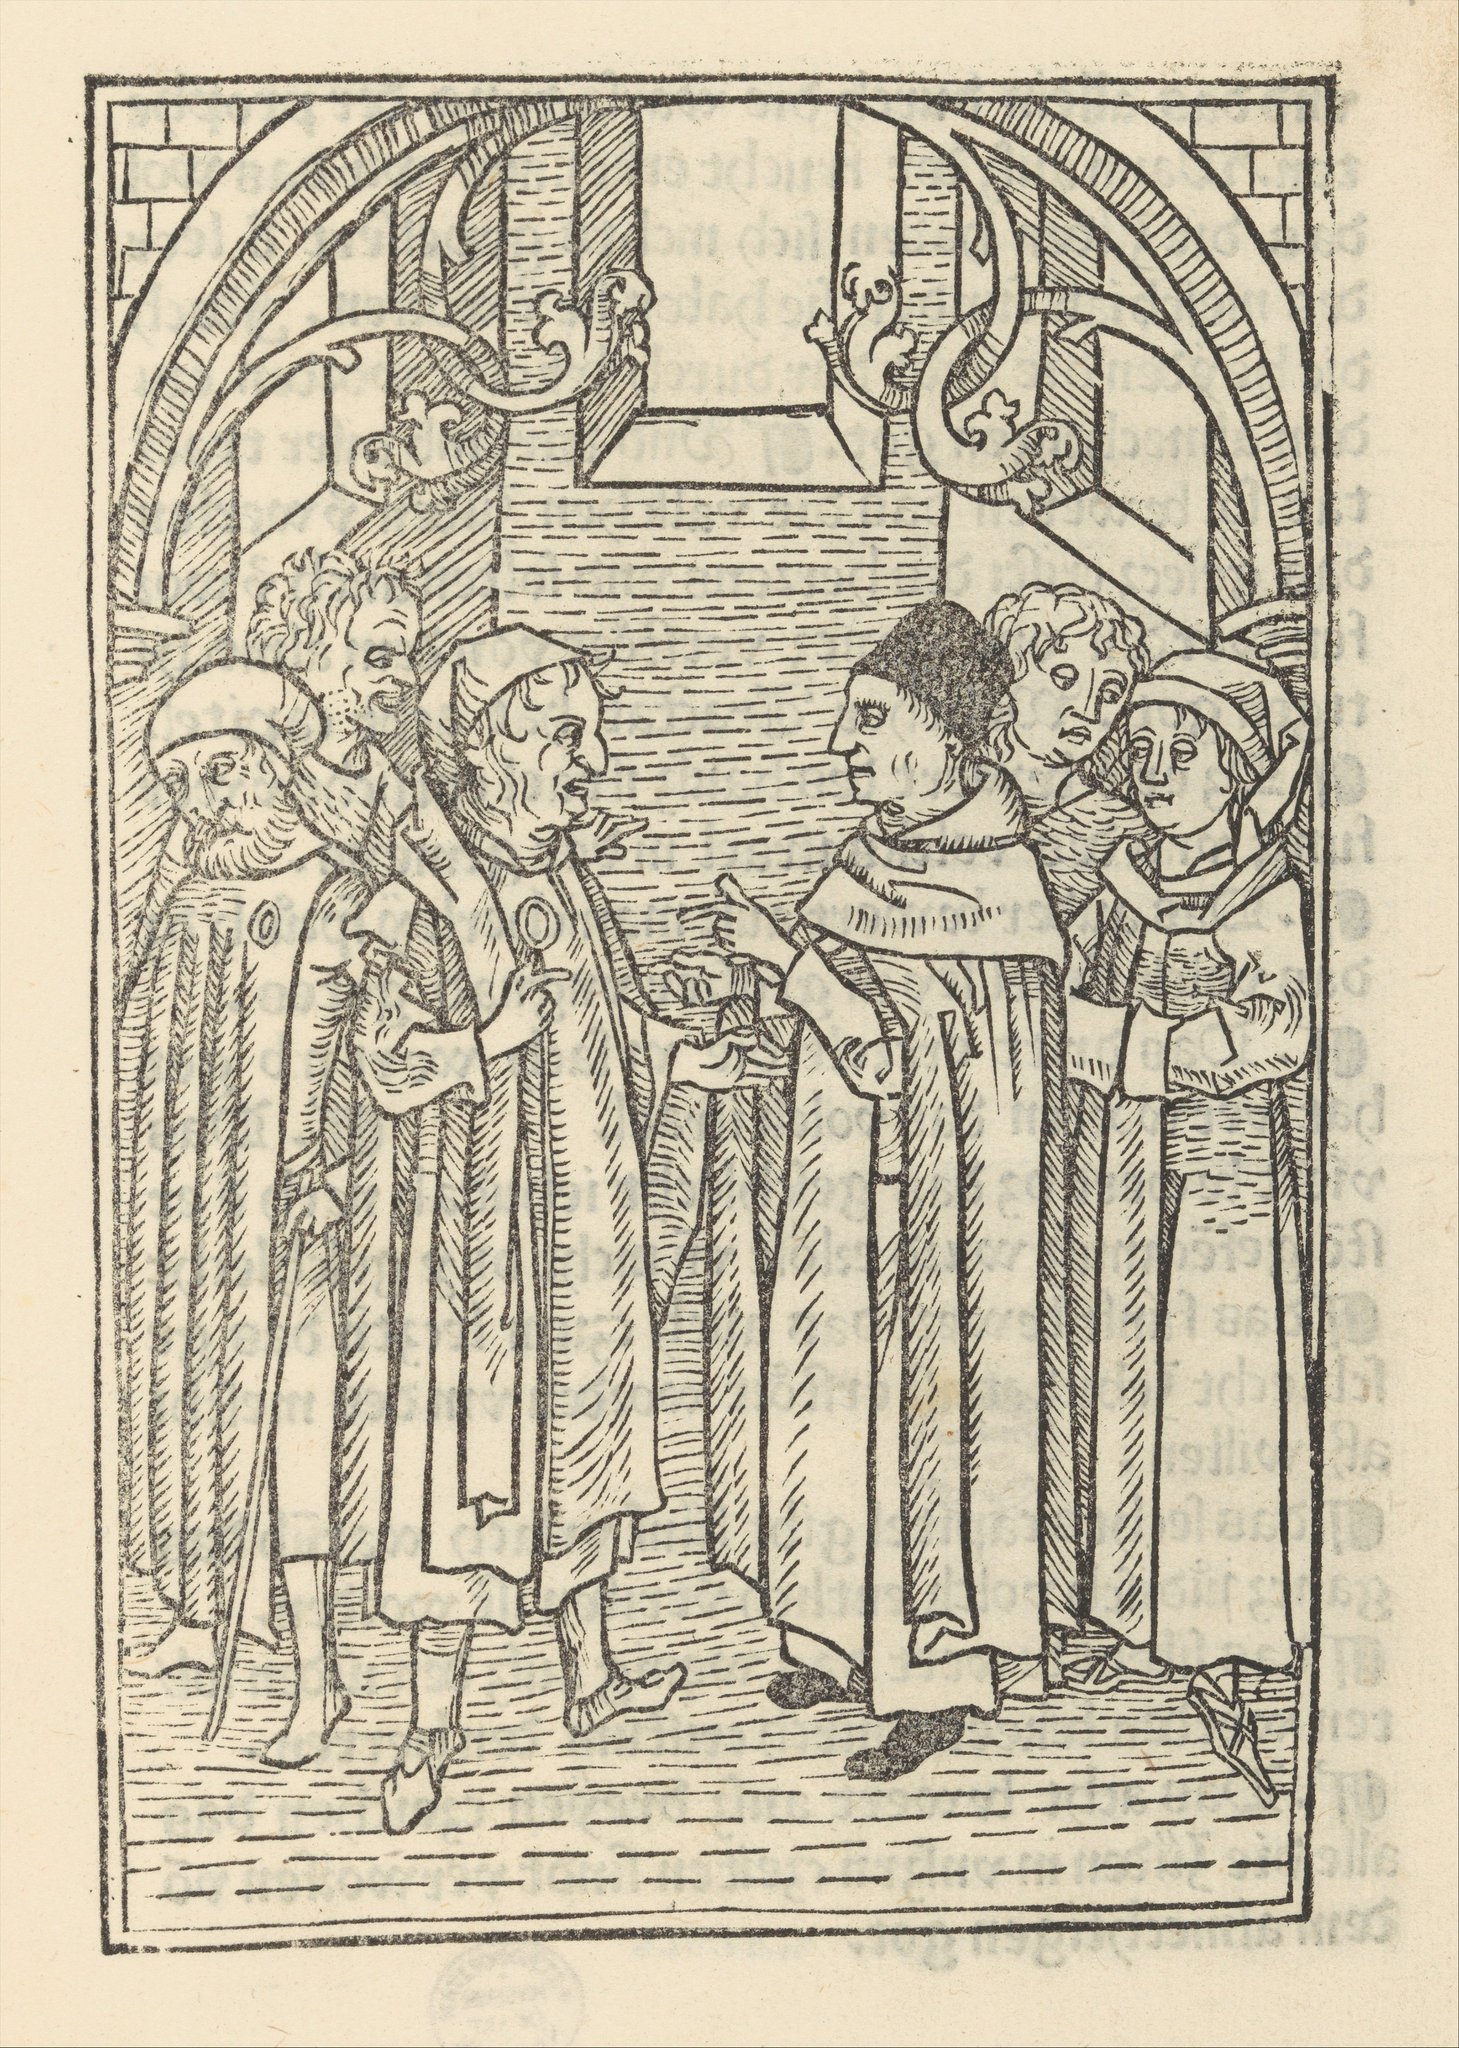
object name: print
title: Page from "Stern des Meschiah"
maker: anonymous, german, 15th century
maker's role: artist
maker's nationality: german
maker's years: 1400-1500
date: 1477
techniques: woodcut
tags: men,women